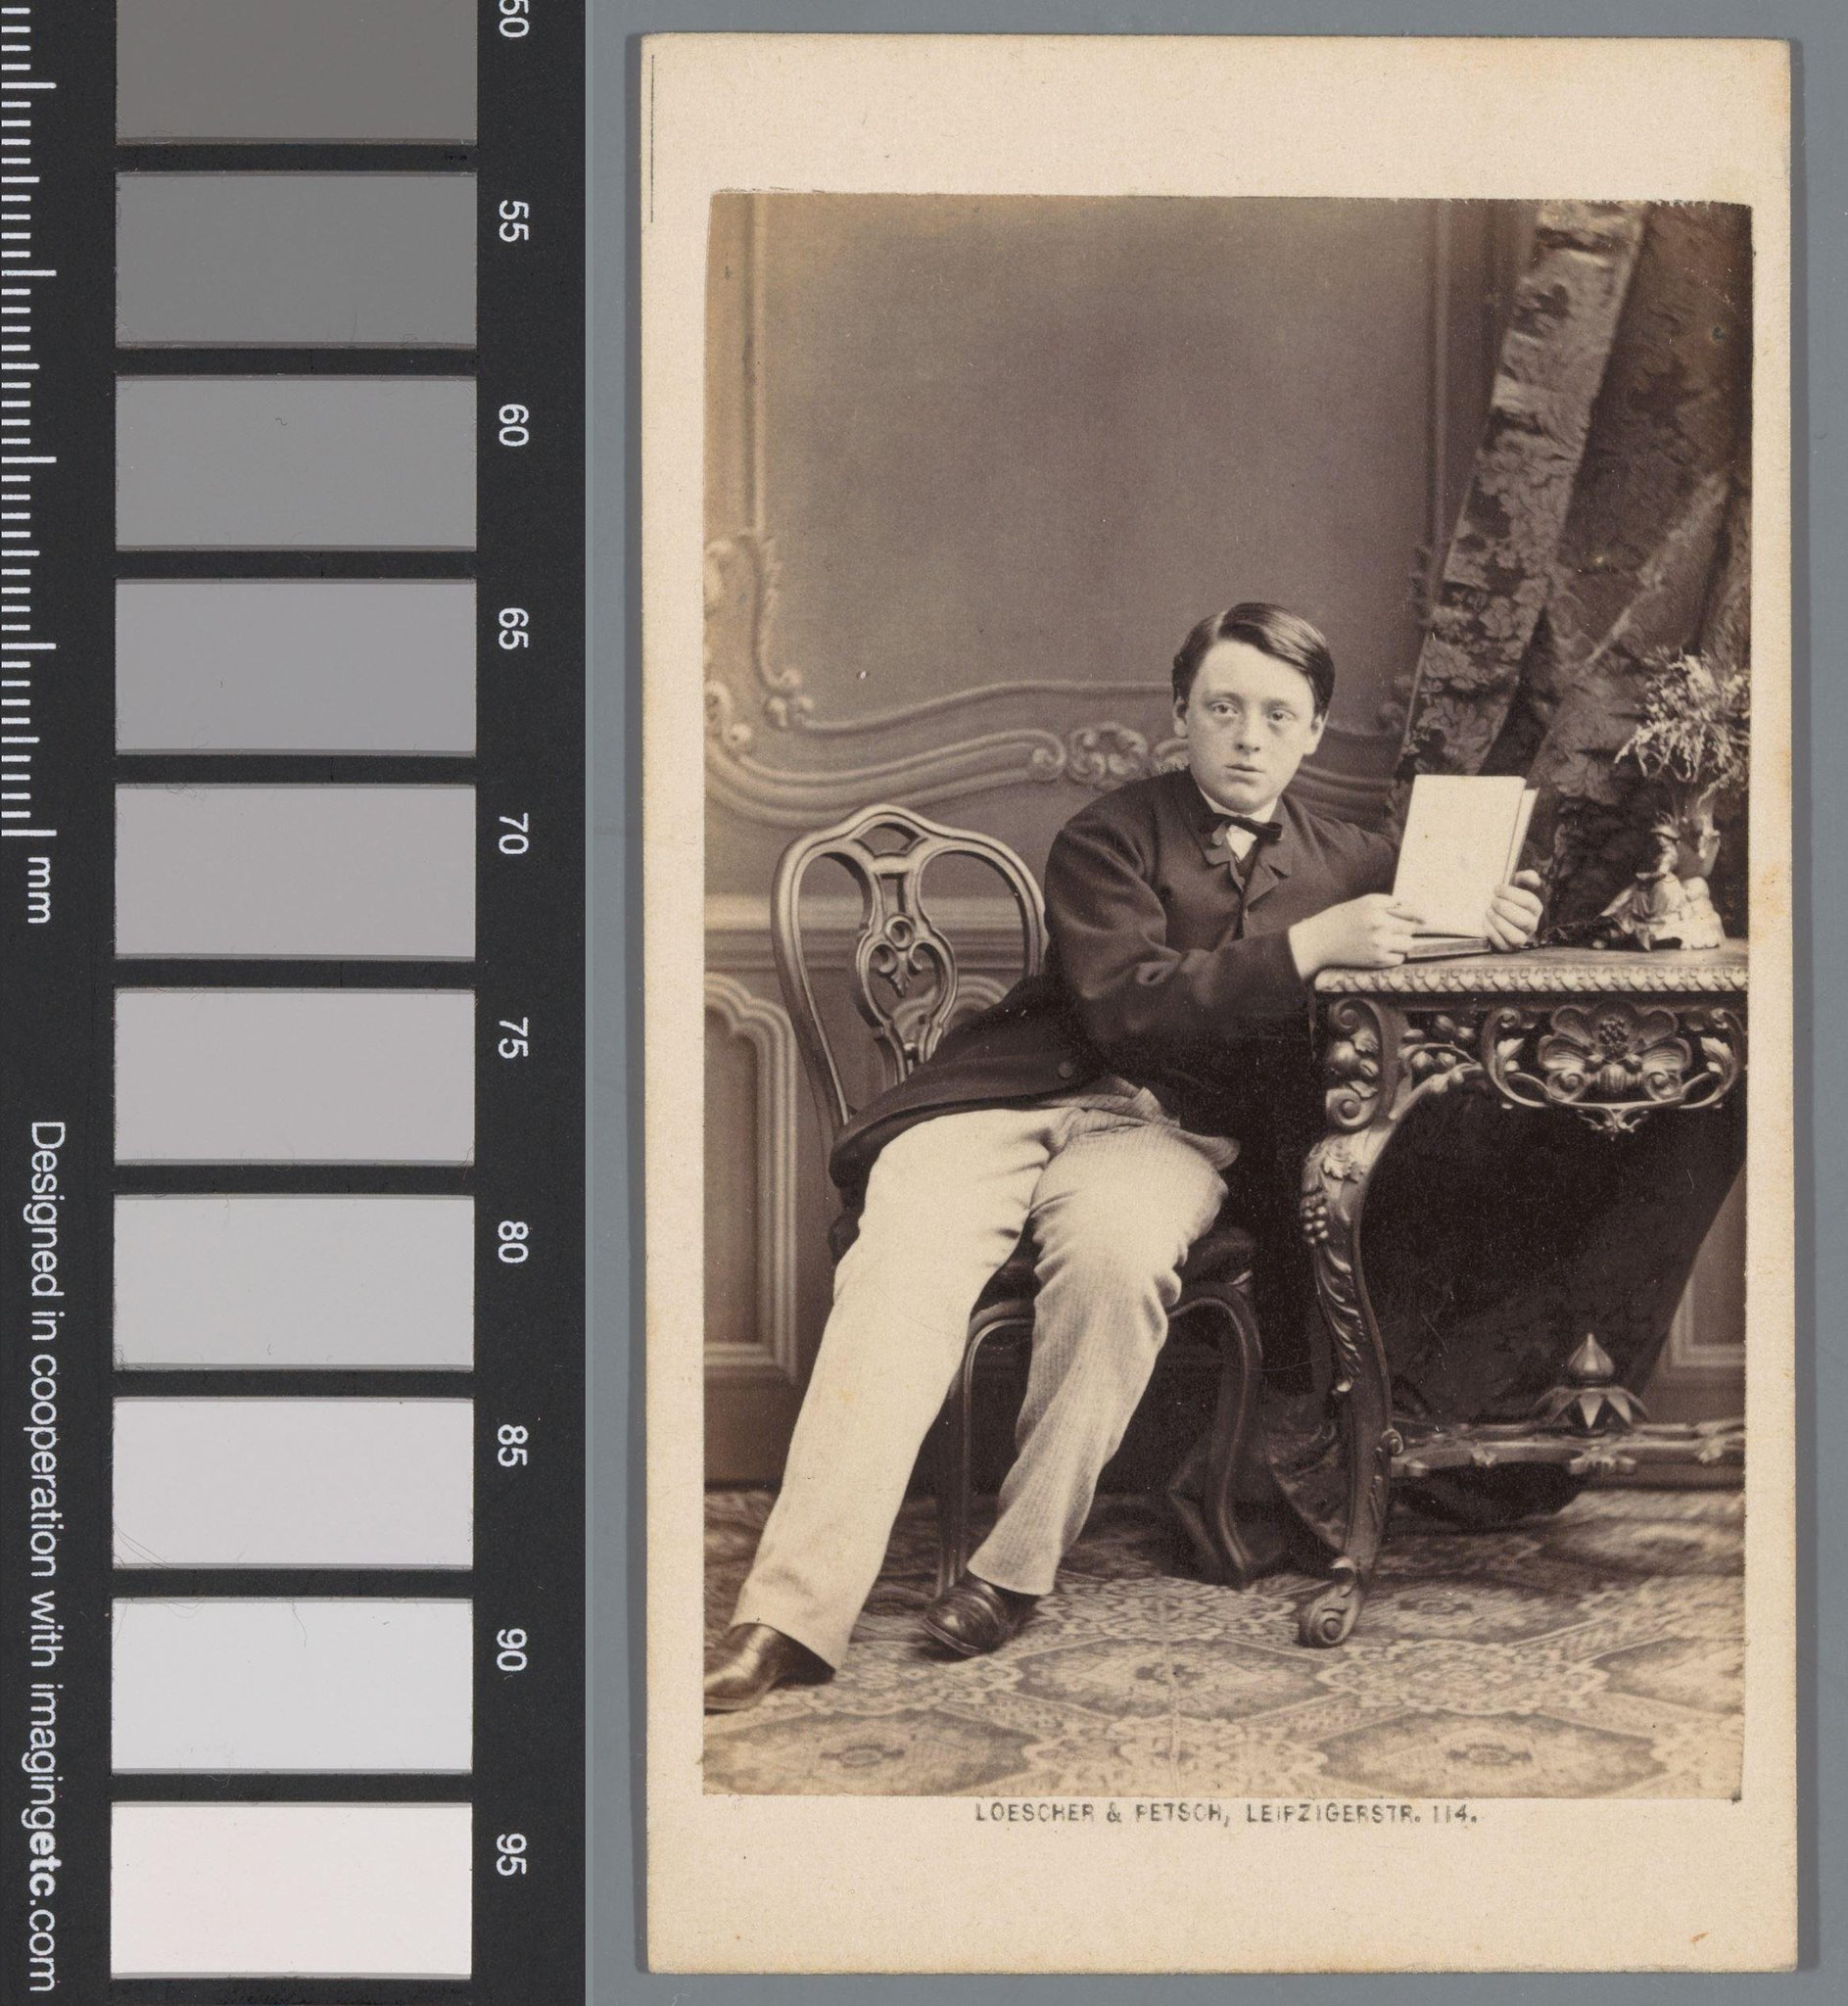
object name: carte de visite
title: Portret van een onbekende jongeman met een boek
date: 1863-1870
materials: cardboard, paper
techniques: albumen print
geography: berlin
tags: youth, adolescent, book - mm - book open, anonymous historical person portrayed, berlin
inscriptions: inscription: ‘Loescher & Petsch, Leipzigerstr. 114.’